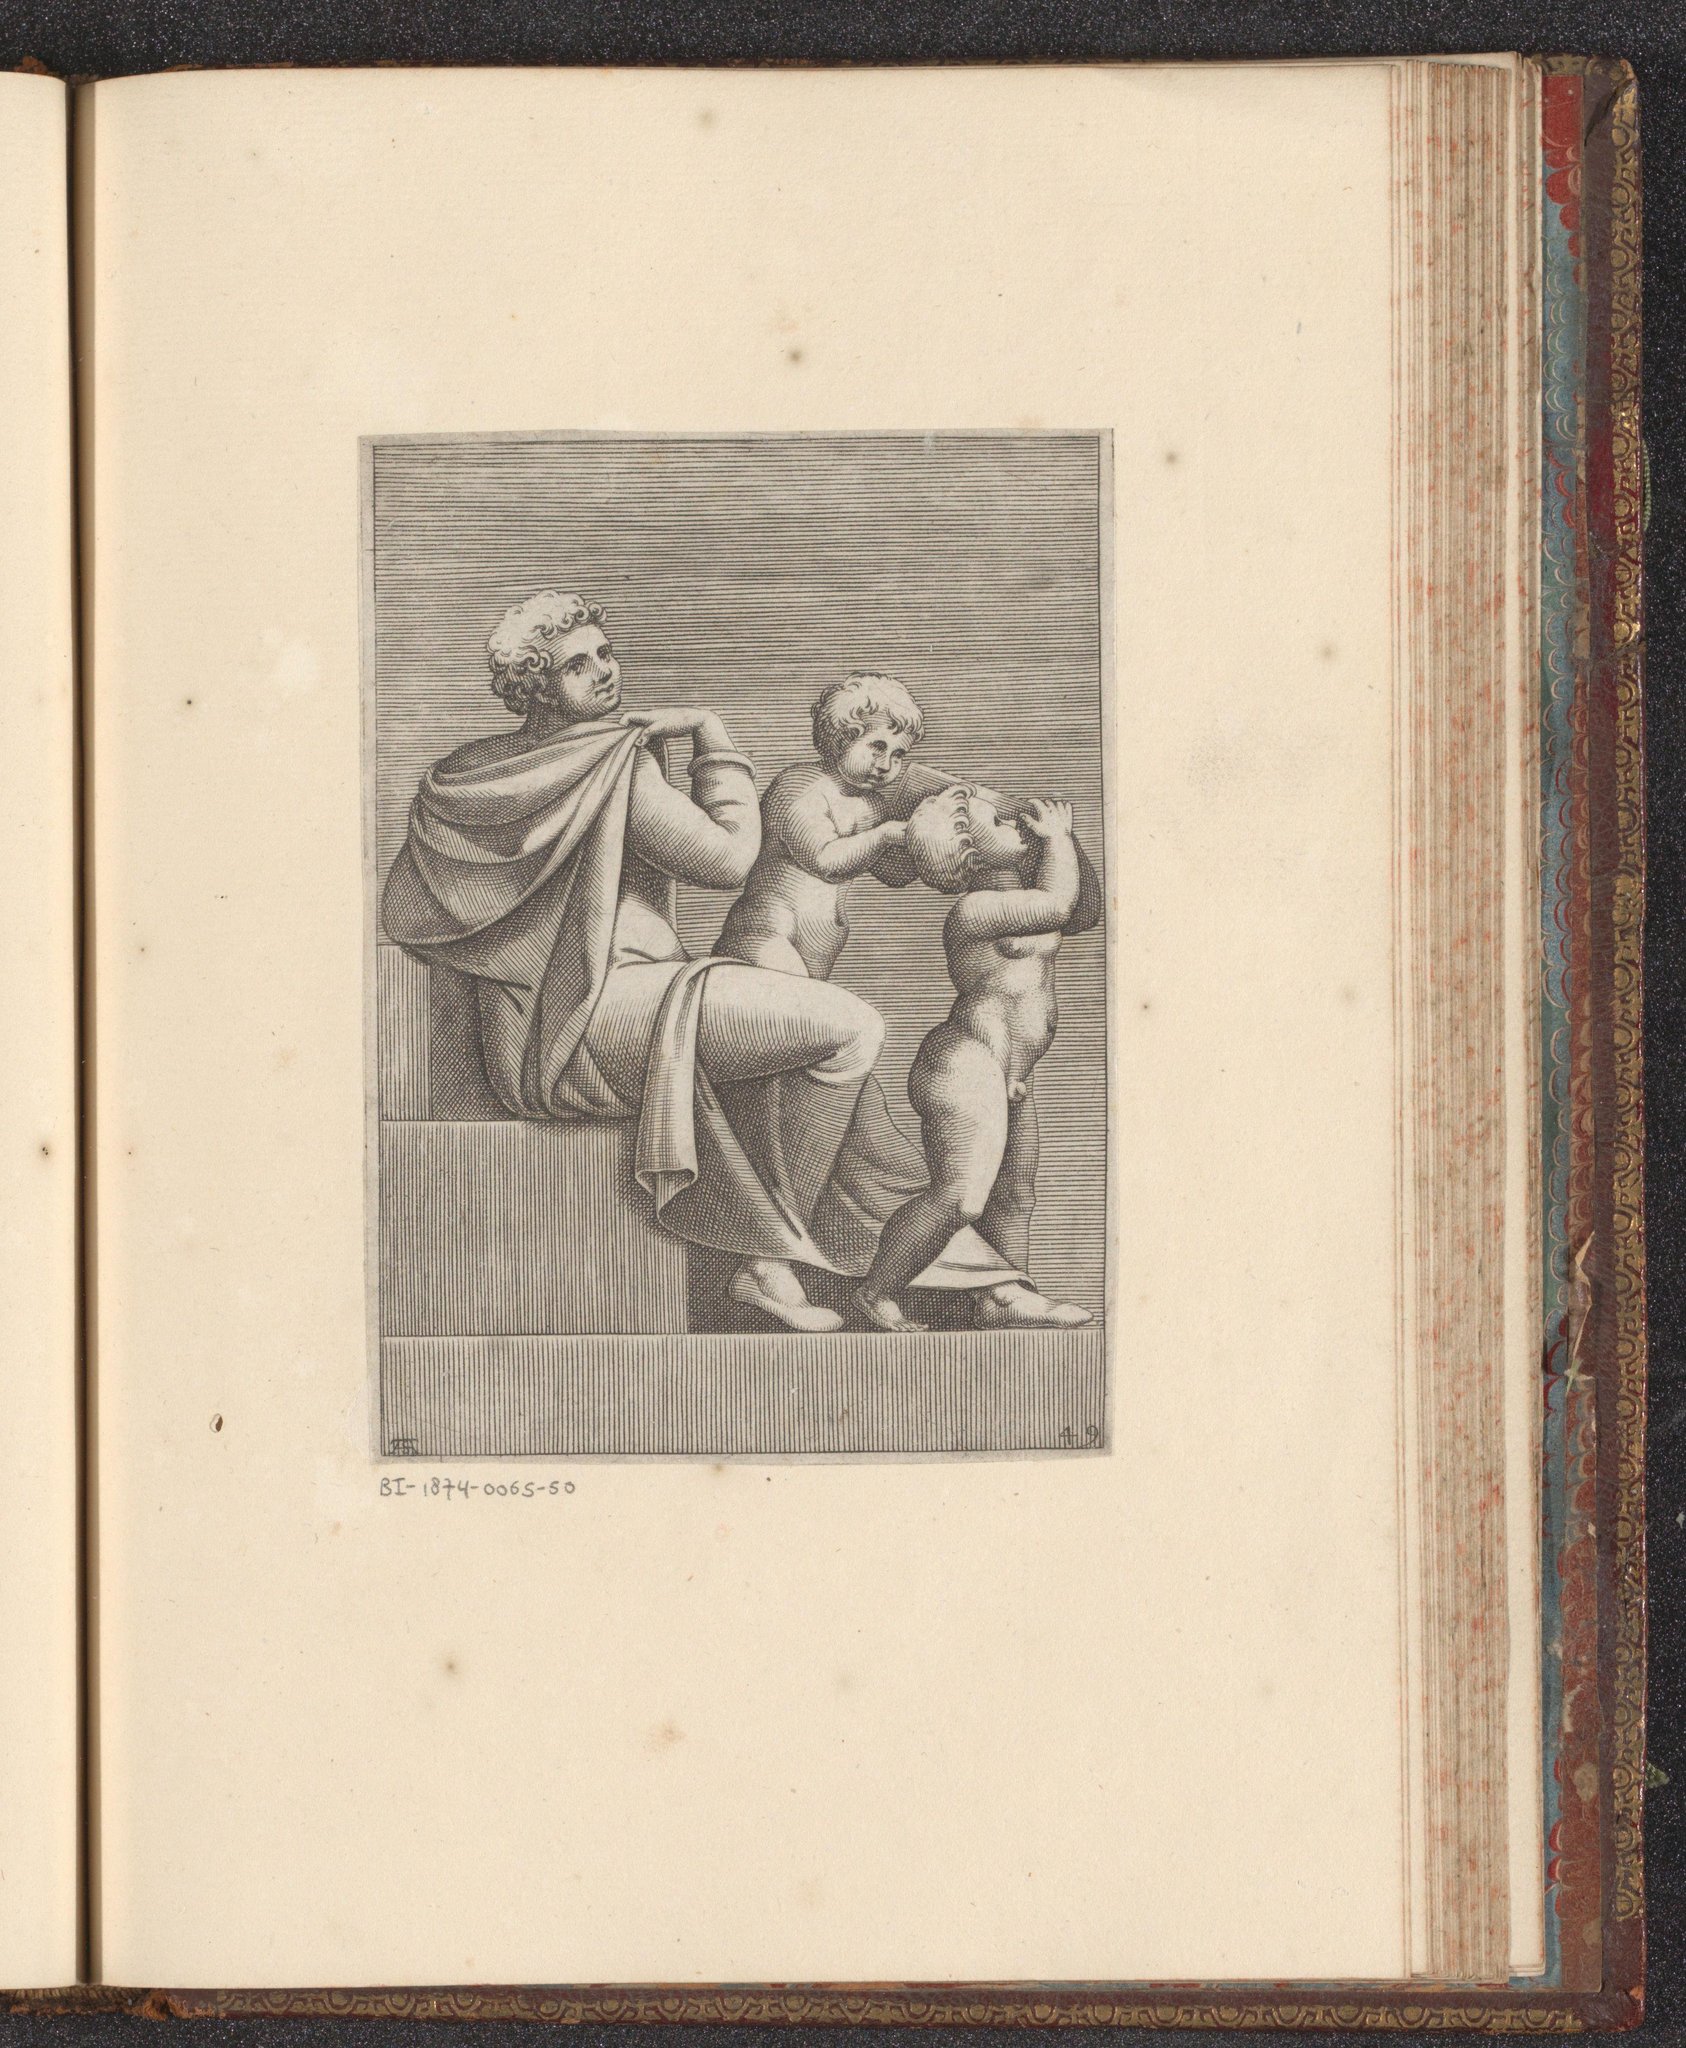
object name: album leaf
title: Schilderingen in de Sixtijnse kapel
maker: adamo scultori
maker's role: painter, print maker, sculptor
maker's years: 1530-1585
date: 1585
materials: paper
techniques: engraving, intaglio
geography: italy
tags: father and child(ren), man and child(ren) (family group)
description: Deze prent maakt deel uit van een serie bestaande uit een titelprent en 72 prenten naar schilderingen door Michelangelo in de Sixtijnse Kapel in het Vaticaan.